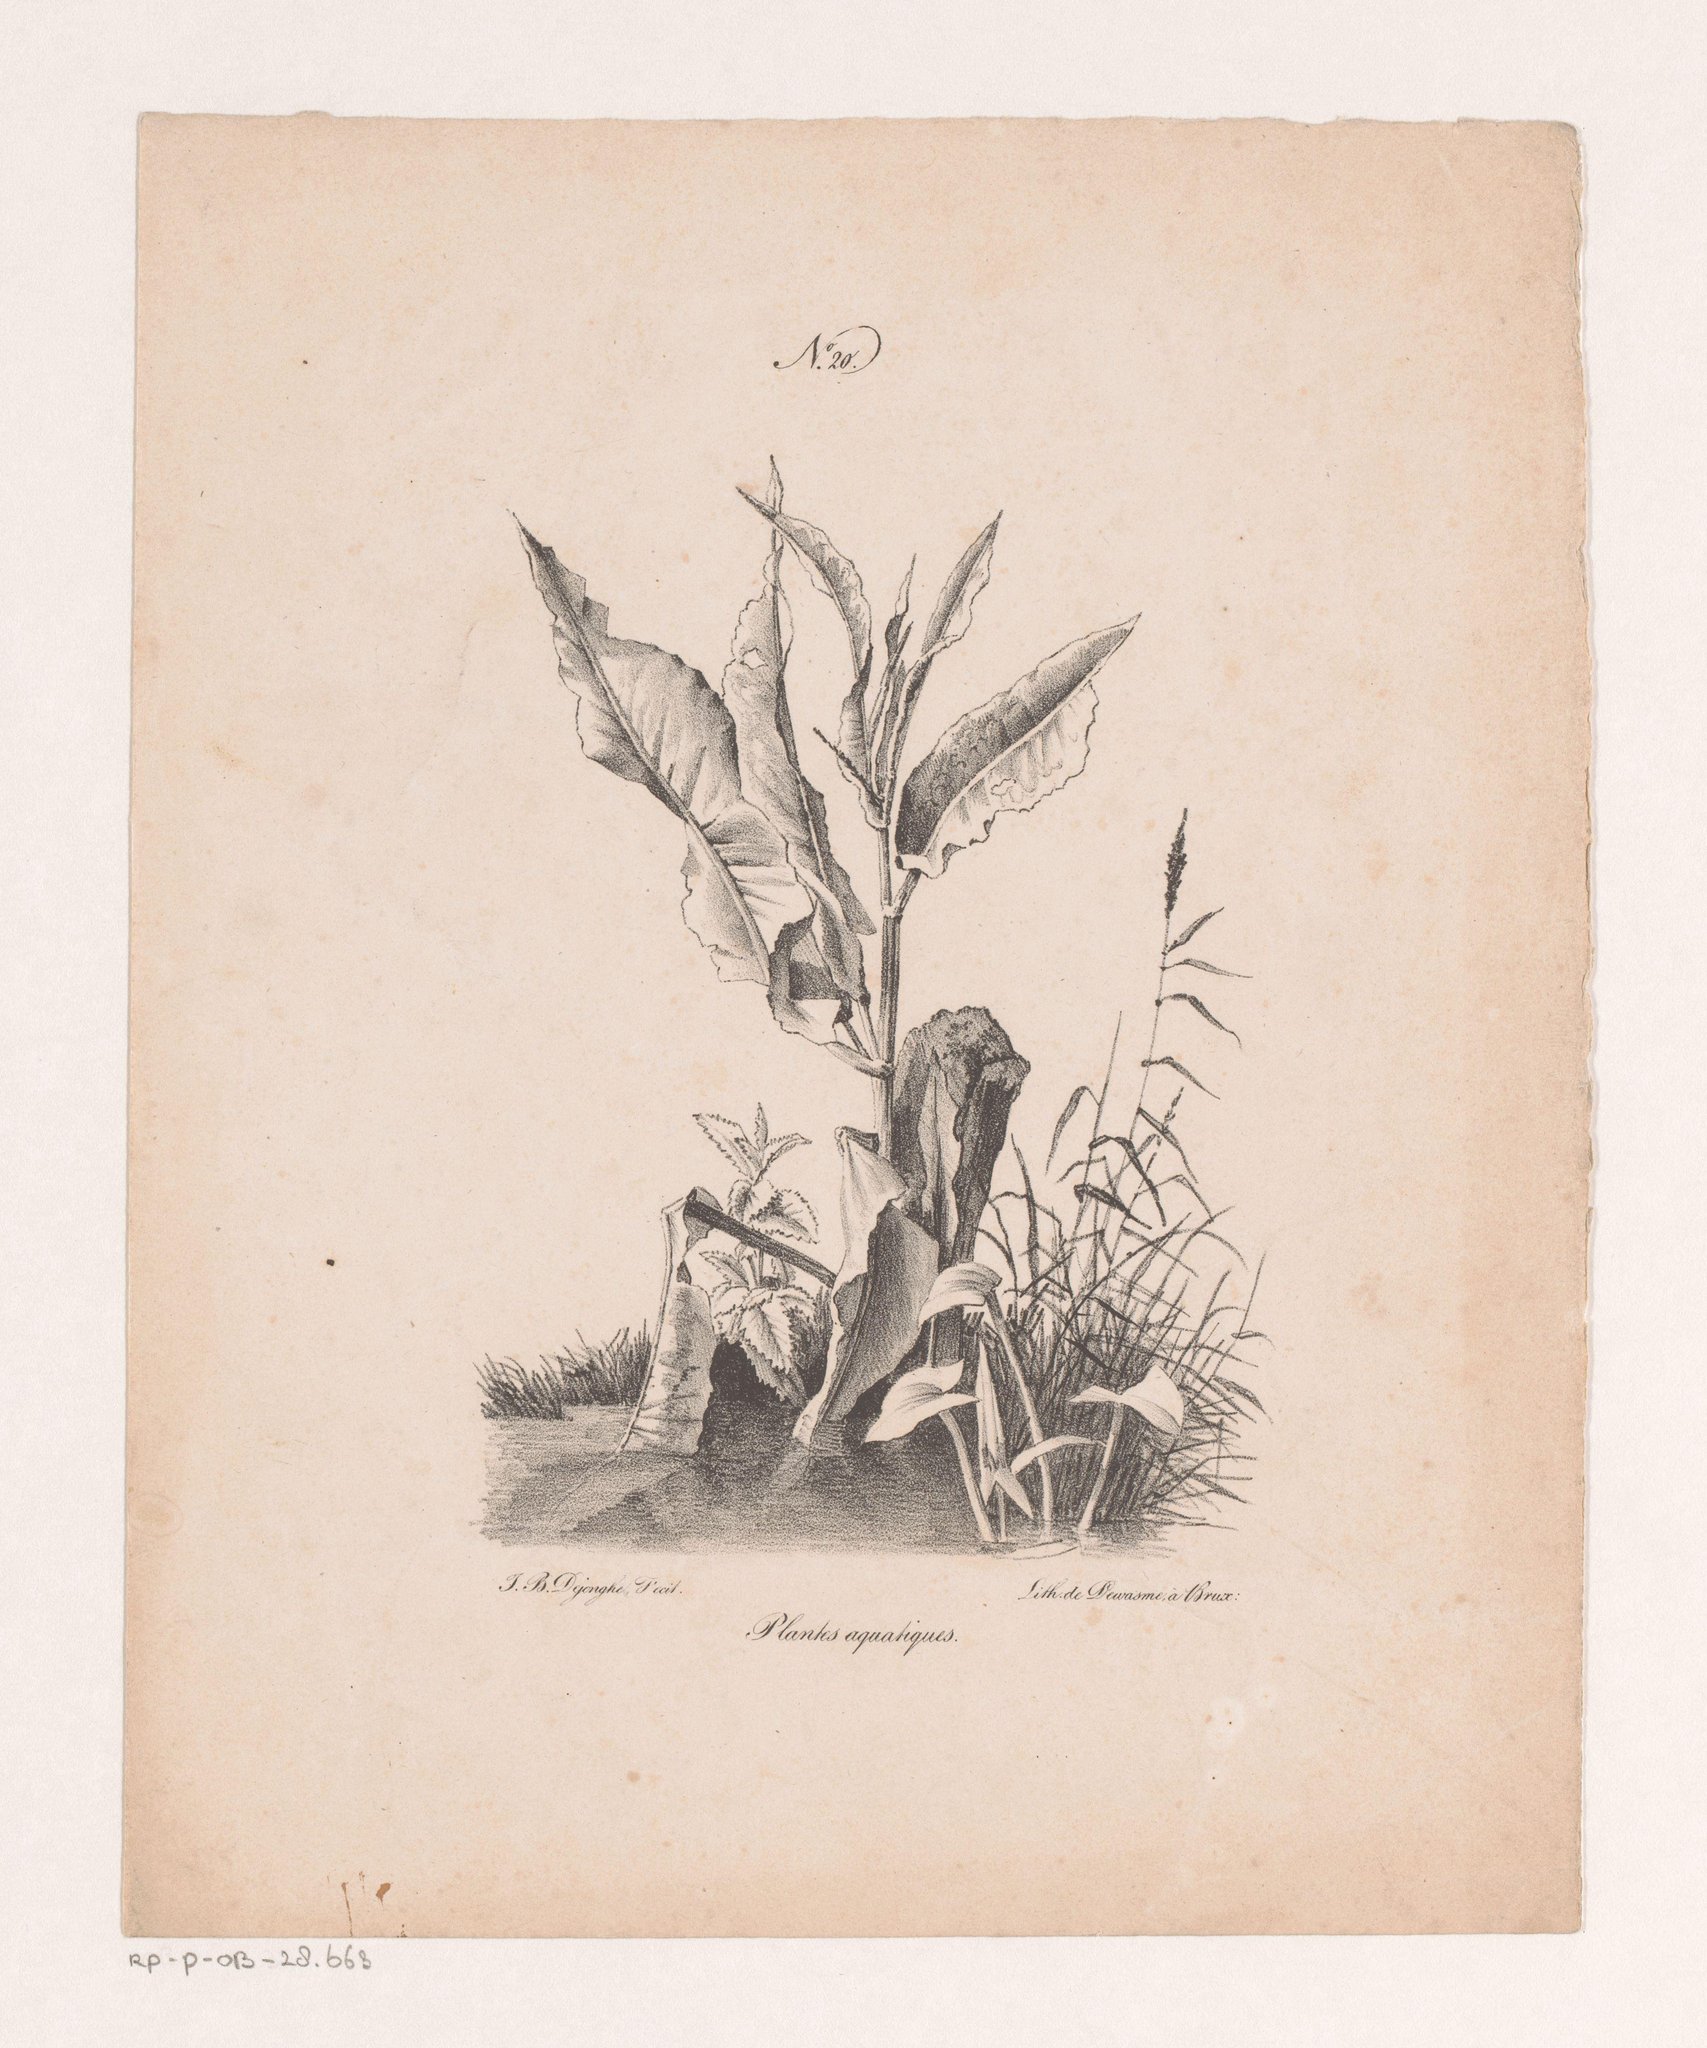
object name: print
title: Principes de paysages dessinés d'après nature et exécutés sur pierre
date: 1826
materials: paper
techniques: lithograph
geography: brussels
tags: plants and herbs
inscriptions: collector's mark: Lugt 2228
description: Deze prent is zeer waarschijnlijk afkomstig uit: J.B. De Jonghe, 'Principes de paysages dessinés d'après nature et exécutés sur pierre', Brussel 1826. Deze bundels met tekenvoorbeelden gebruikte De Jonghe tijdens zijn docentschap in Kortwijk. Zie: L. Pil 1993.